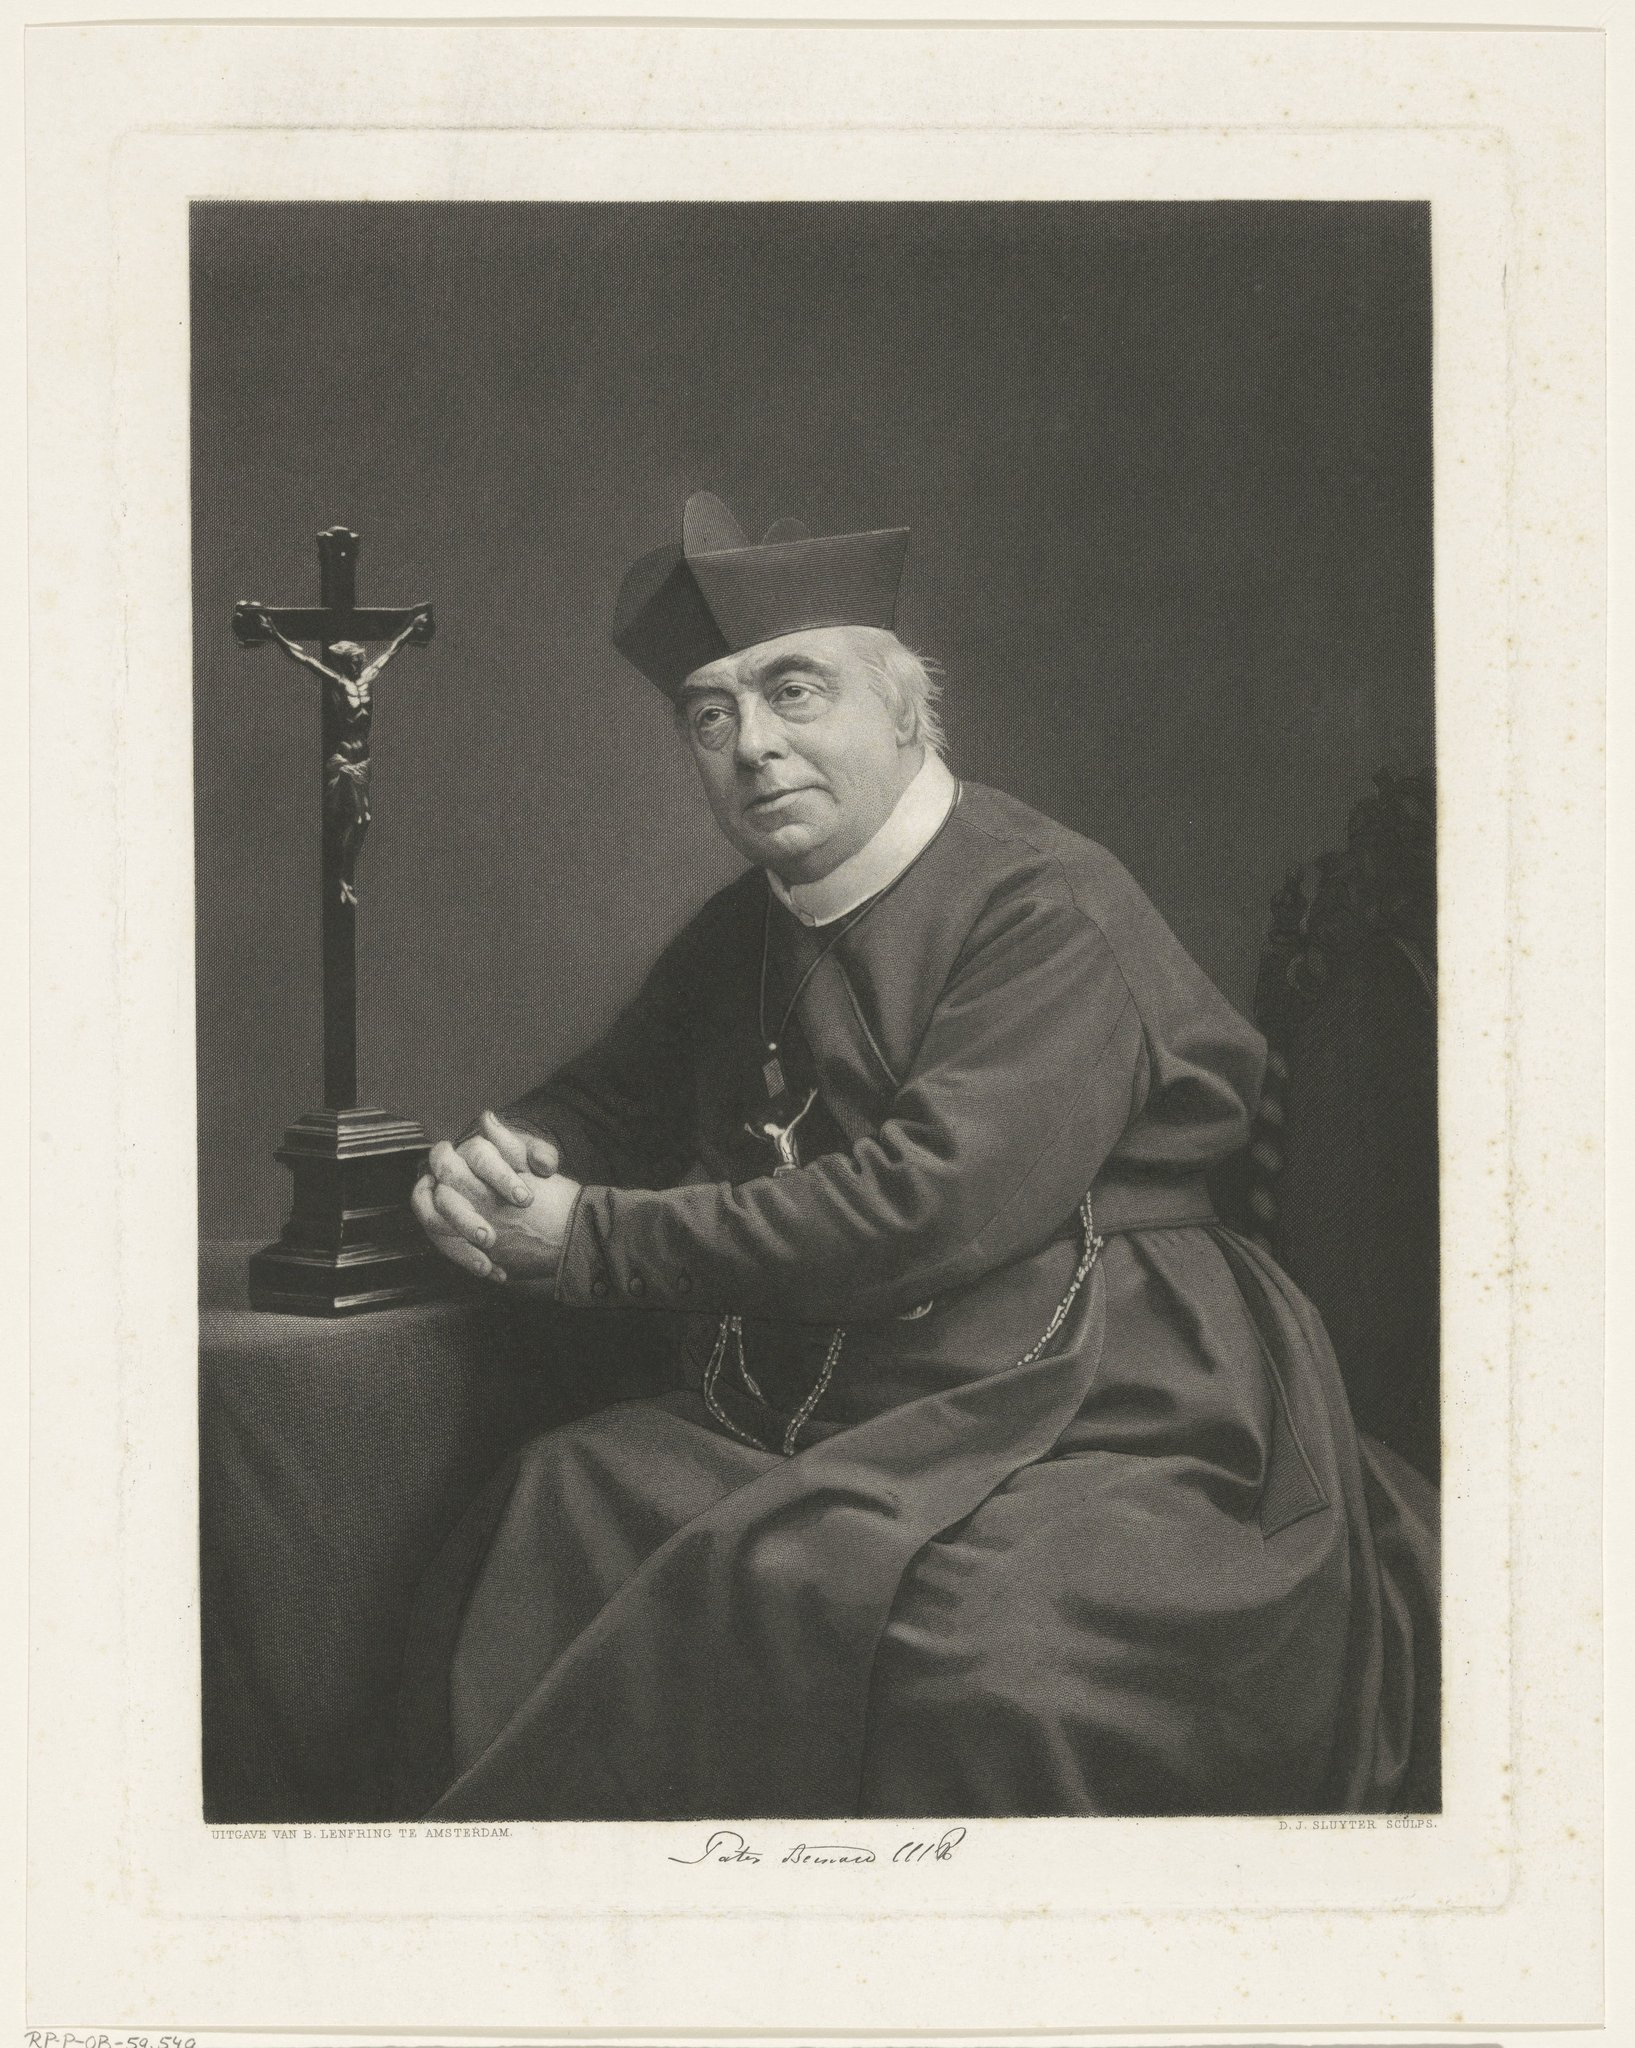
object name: print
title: Portret van pater Bernard Hafkenscheid, volksmissionaris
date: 1855-1886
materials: paper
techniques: aquatint, etching, engraving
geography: amsterdam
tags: amsterdam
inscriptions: collector's mark: Lugt 964, inscription: ‘B. Hafkenscheidt’